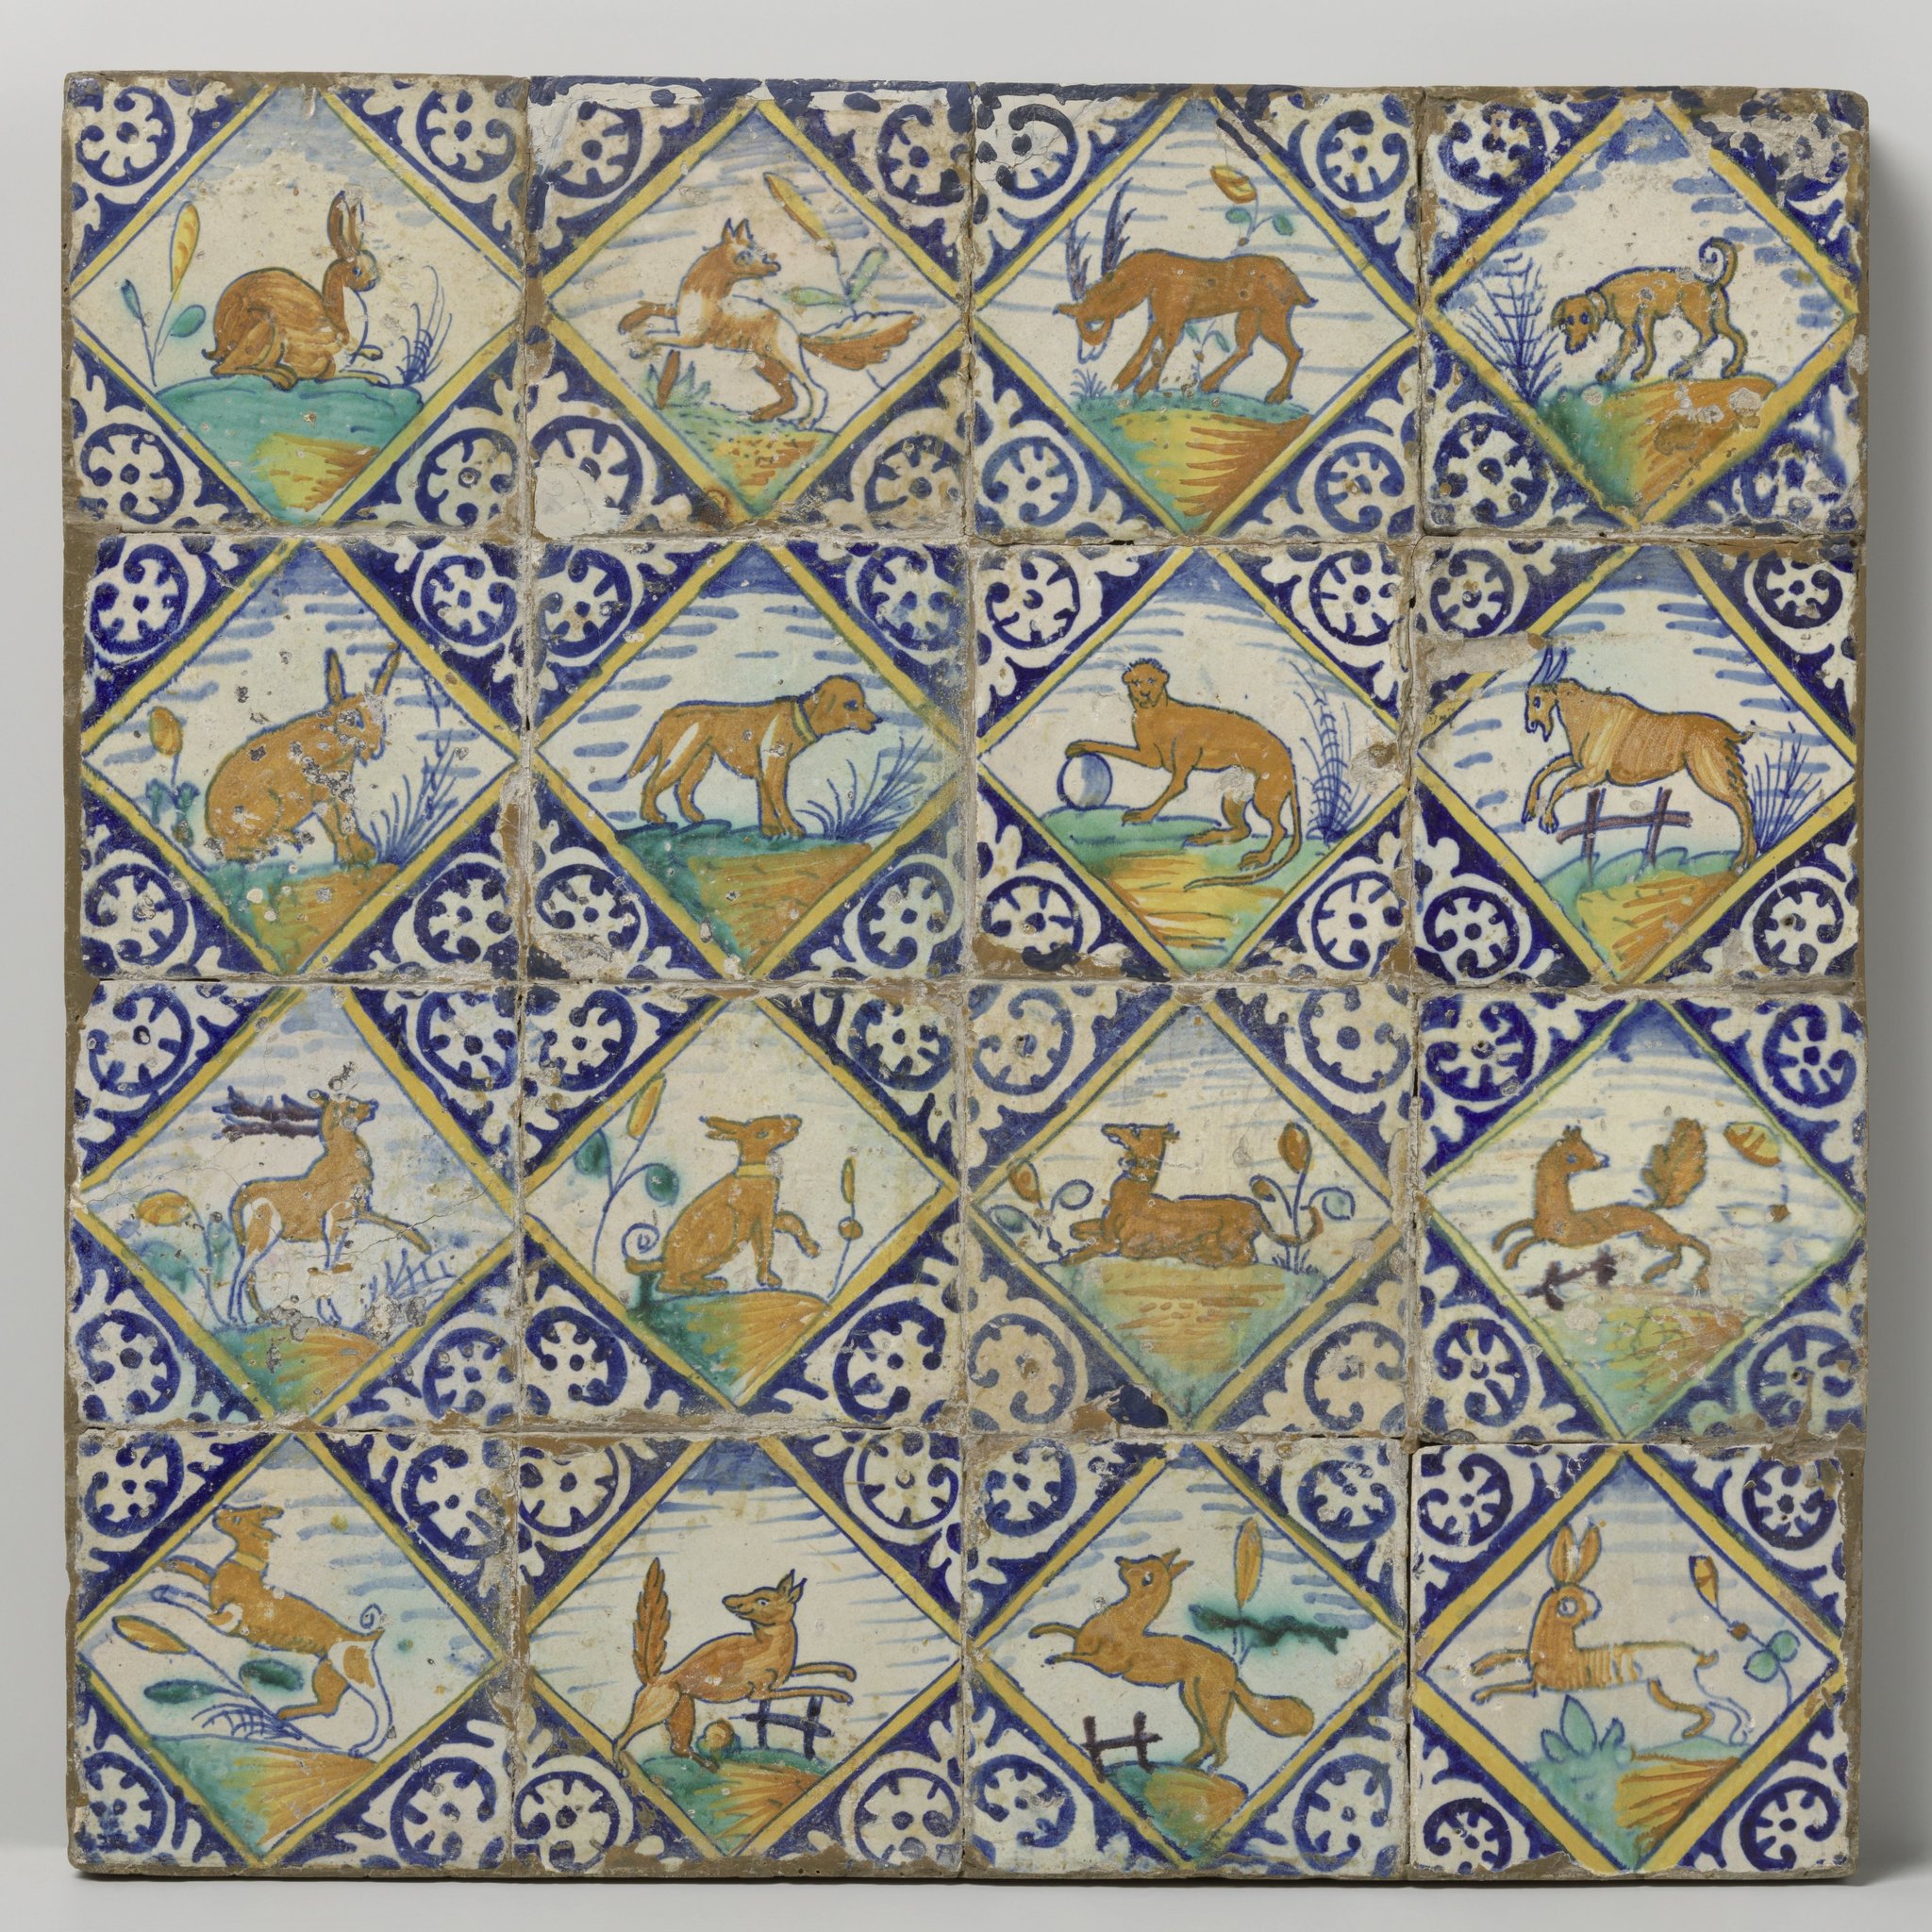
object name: diertegel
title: Veld van zestien tegels met dieren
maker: Anonymous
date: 1580-1625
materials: earthenware, glaze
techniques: maiolica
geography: netherlands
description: Veld van zestien tegels (4 x 4) elk met een veelkleurig (blauw, oranje, geel, groen en paars) geschilderd dier binnen een kwadraat. In de hoeken, vultechniek ornament.